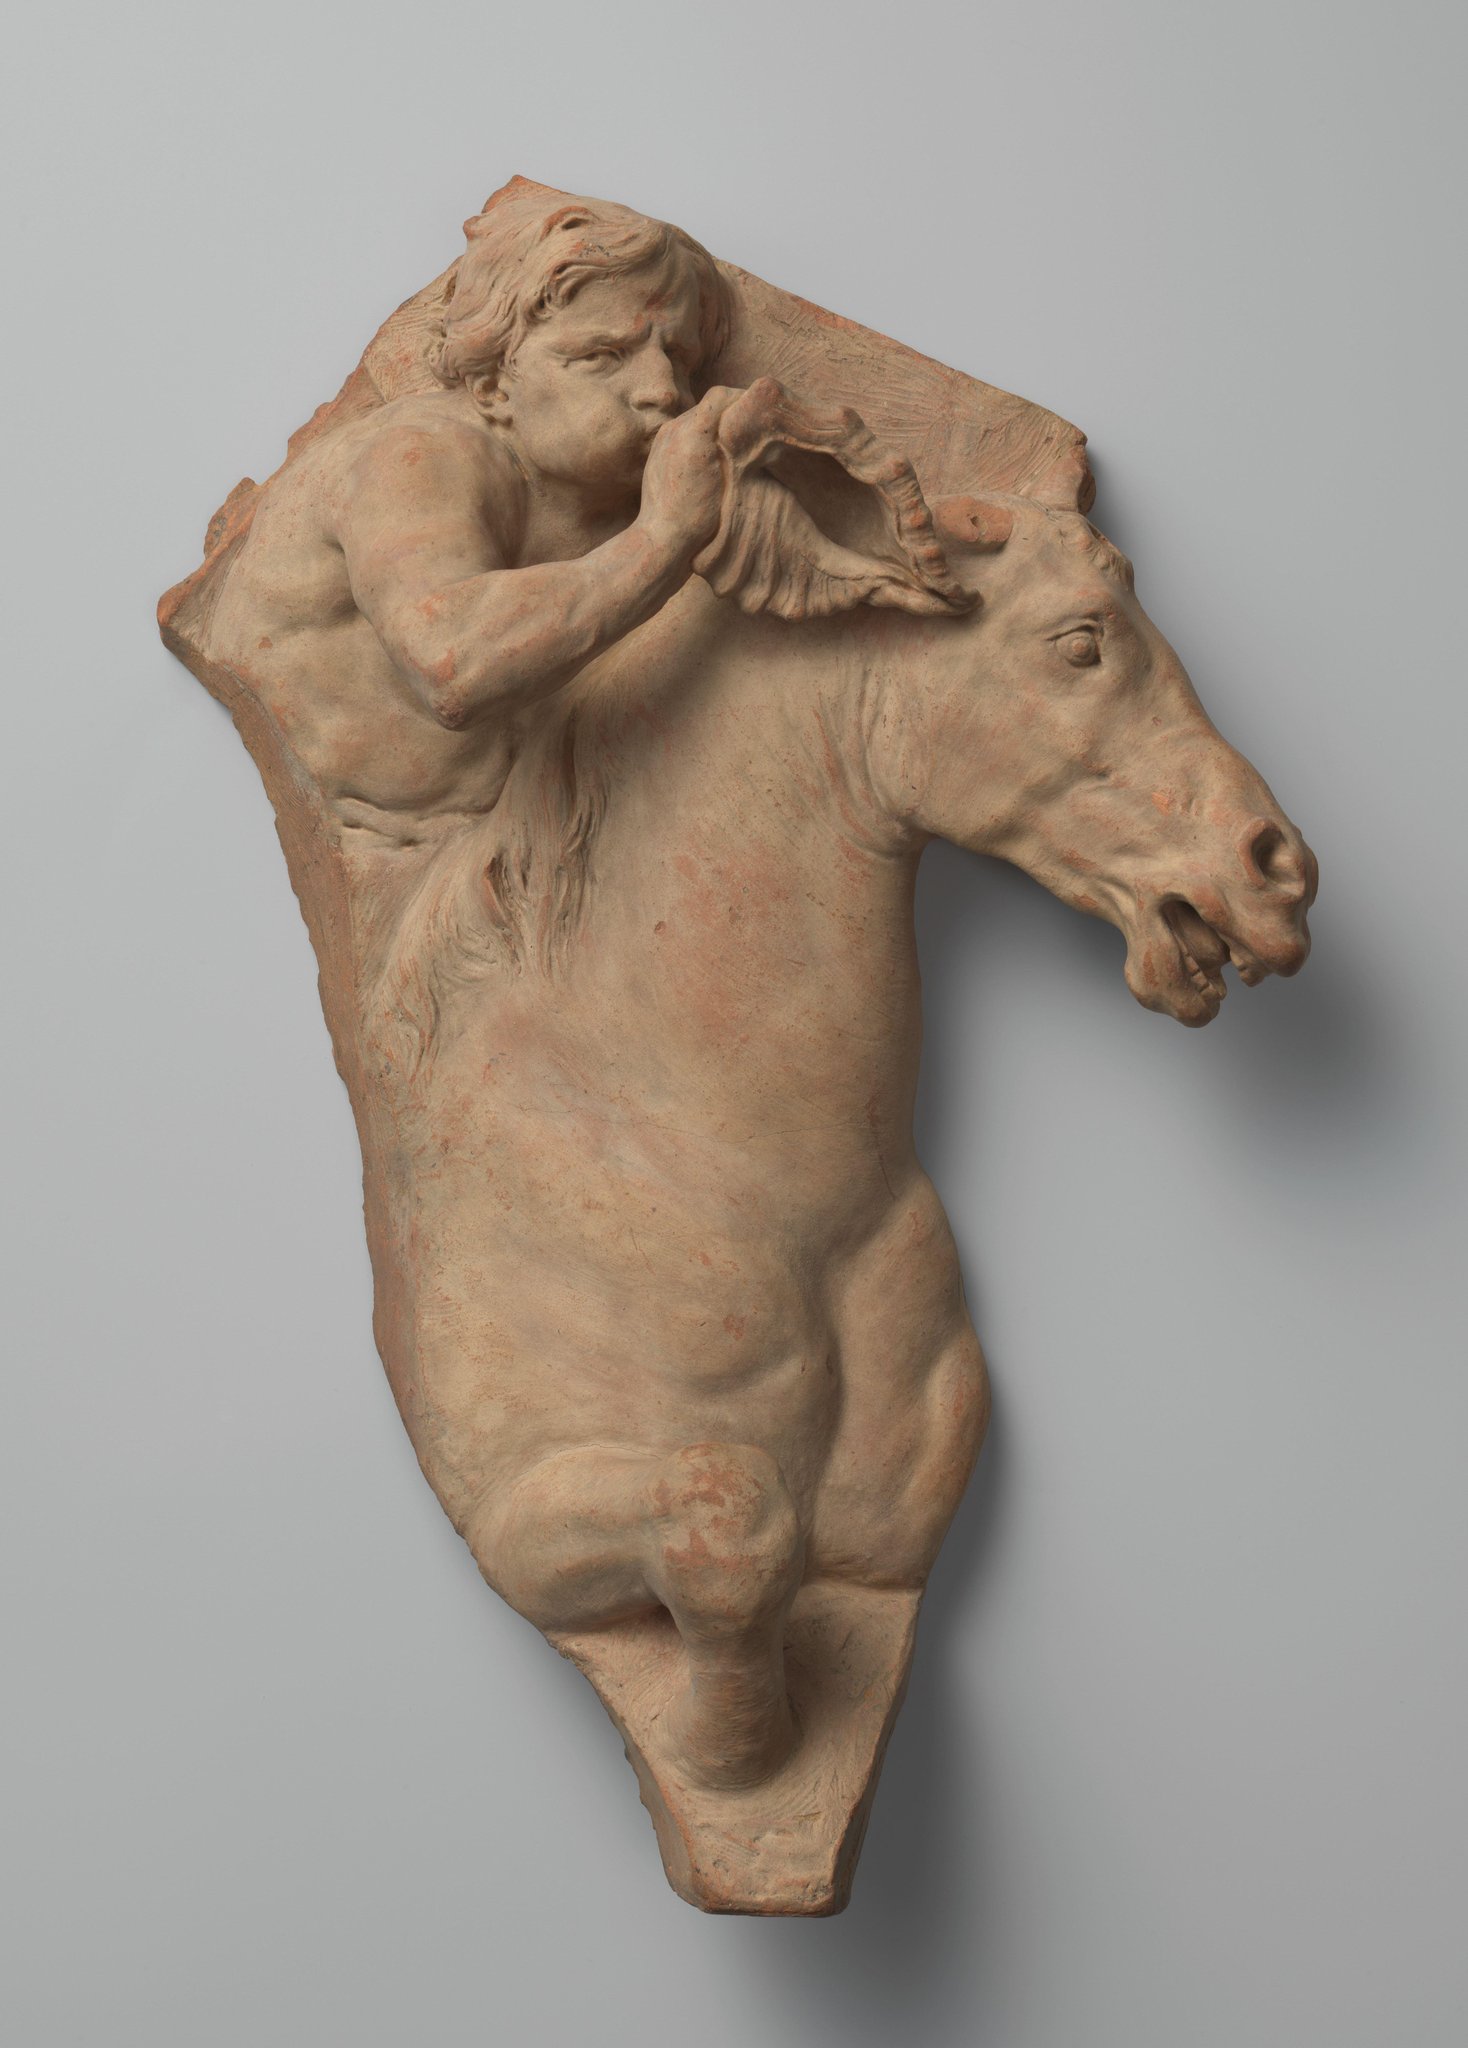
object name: model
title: Triton on a Hippocampus, Part of a Model for the East Tympanum of the Amsterdam Town Hall (now Royal Palace) at Dam Square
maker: artus quellinus (i)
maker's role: draughtsman, print maker, sculptor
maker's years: 1609-1668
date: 1650-1653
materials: terracotta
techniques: modeling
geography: amsterdam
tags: triton(s), sea-horse, hippocamp, 'hippocampus', (horse/fish) (mythological hybrid monster)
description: The front and rear elevation of the Town Hall are each dominated by a sculpted marble tympanum approximately twenty metres wide and surmounted by bronze statues. The side facing the Dam, where ships could moor, depicts the seas paying homage to Amsterdam. Parts of the tympanum design have been preserved, including this Maid of Amsterdam and all kinds of mythological sea creatures, such as nereids and tritons on dolphins and seahorses.